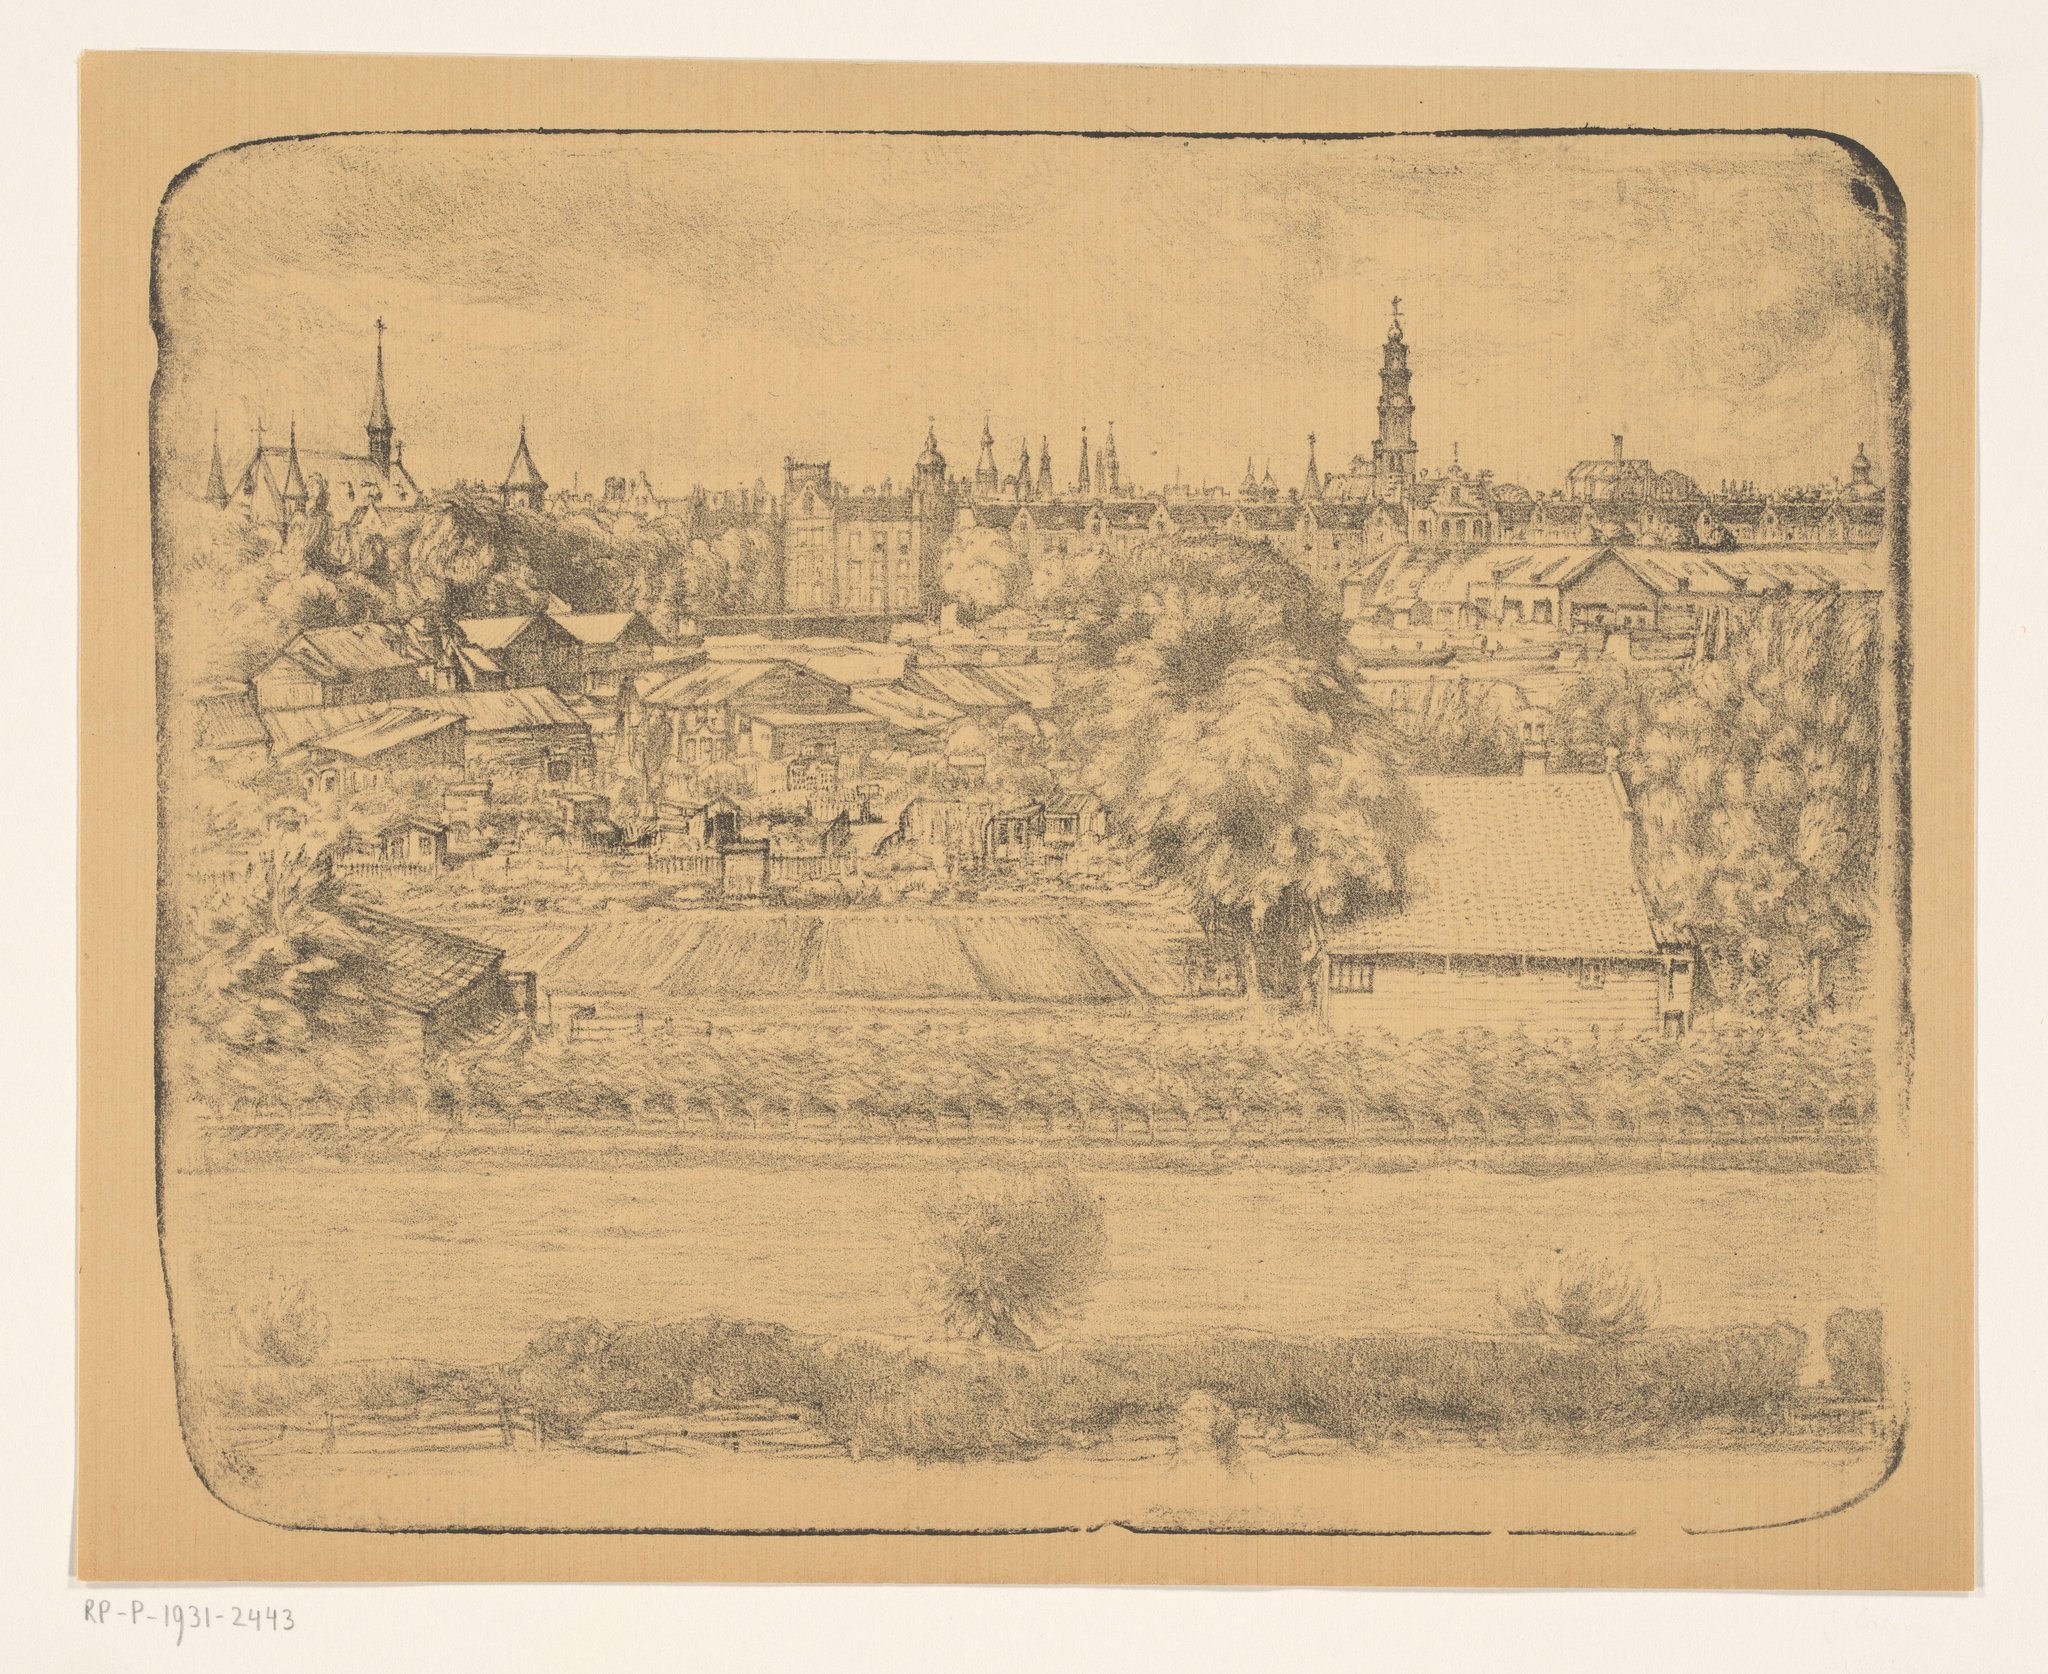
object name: print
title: Ontmoeting in het bos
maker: hendrik jozef franciscus van der poorten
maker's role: draughtsman, print maker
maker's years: 1789-1874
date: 1799-1874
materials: paper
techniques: etching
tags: riding a horse, ass, or mule; rider, horseman, lovers' meeting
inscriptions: collector's mark: Lugt 1485, collector's mark: Lugt 2228